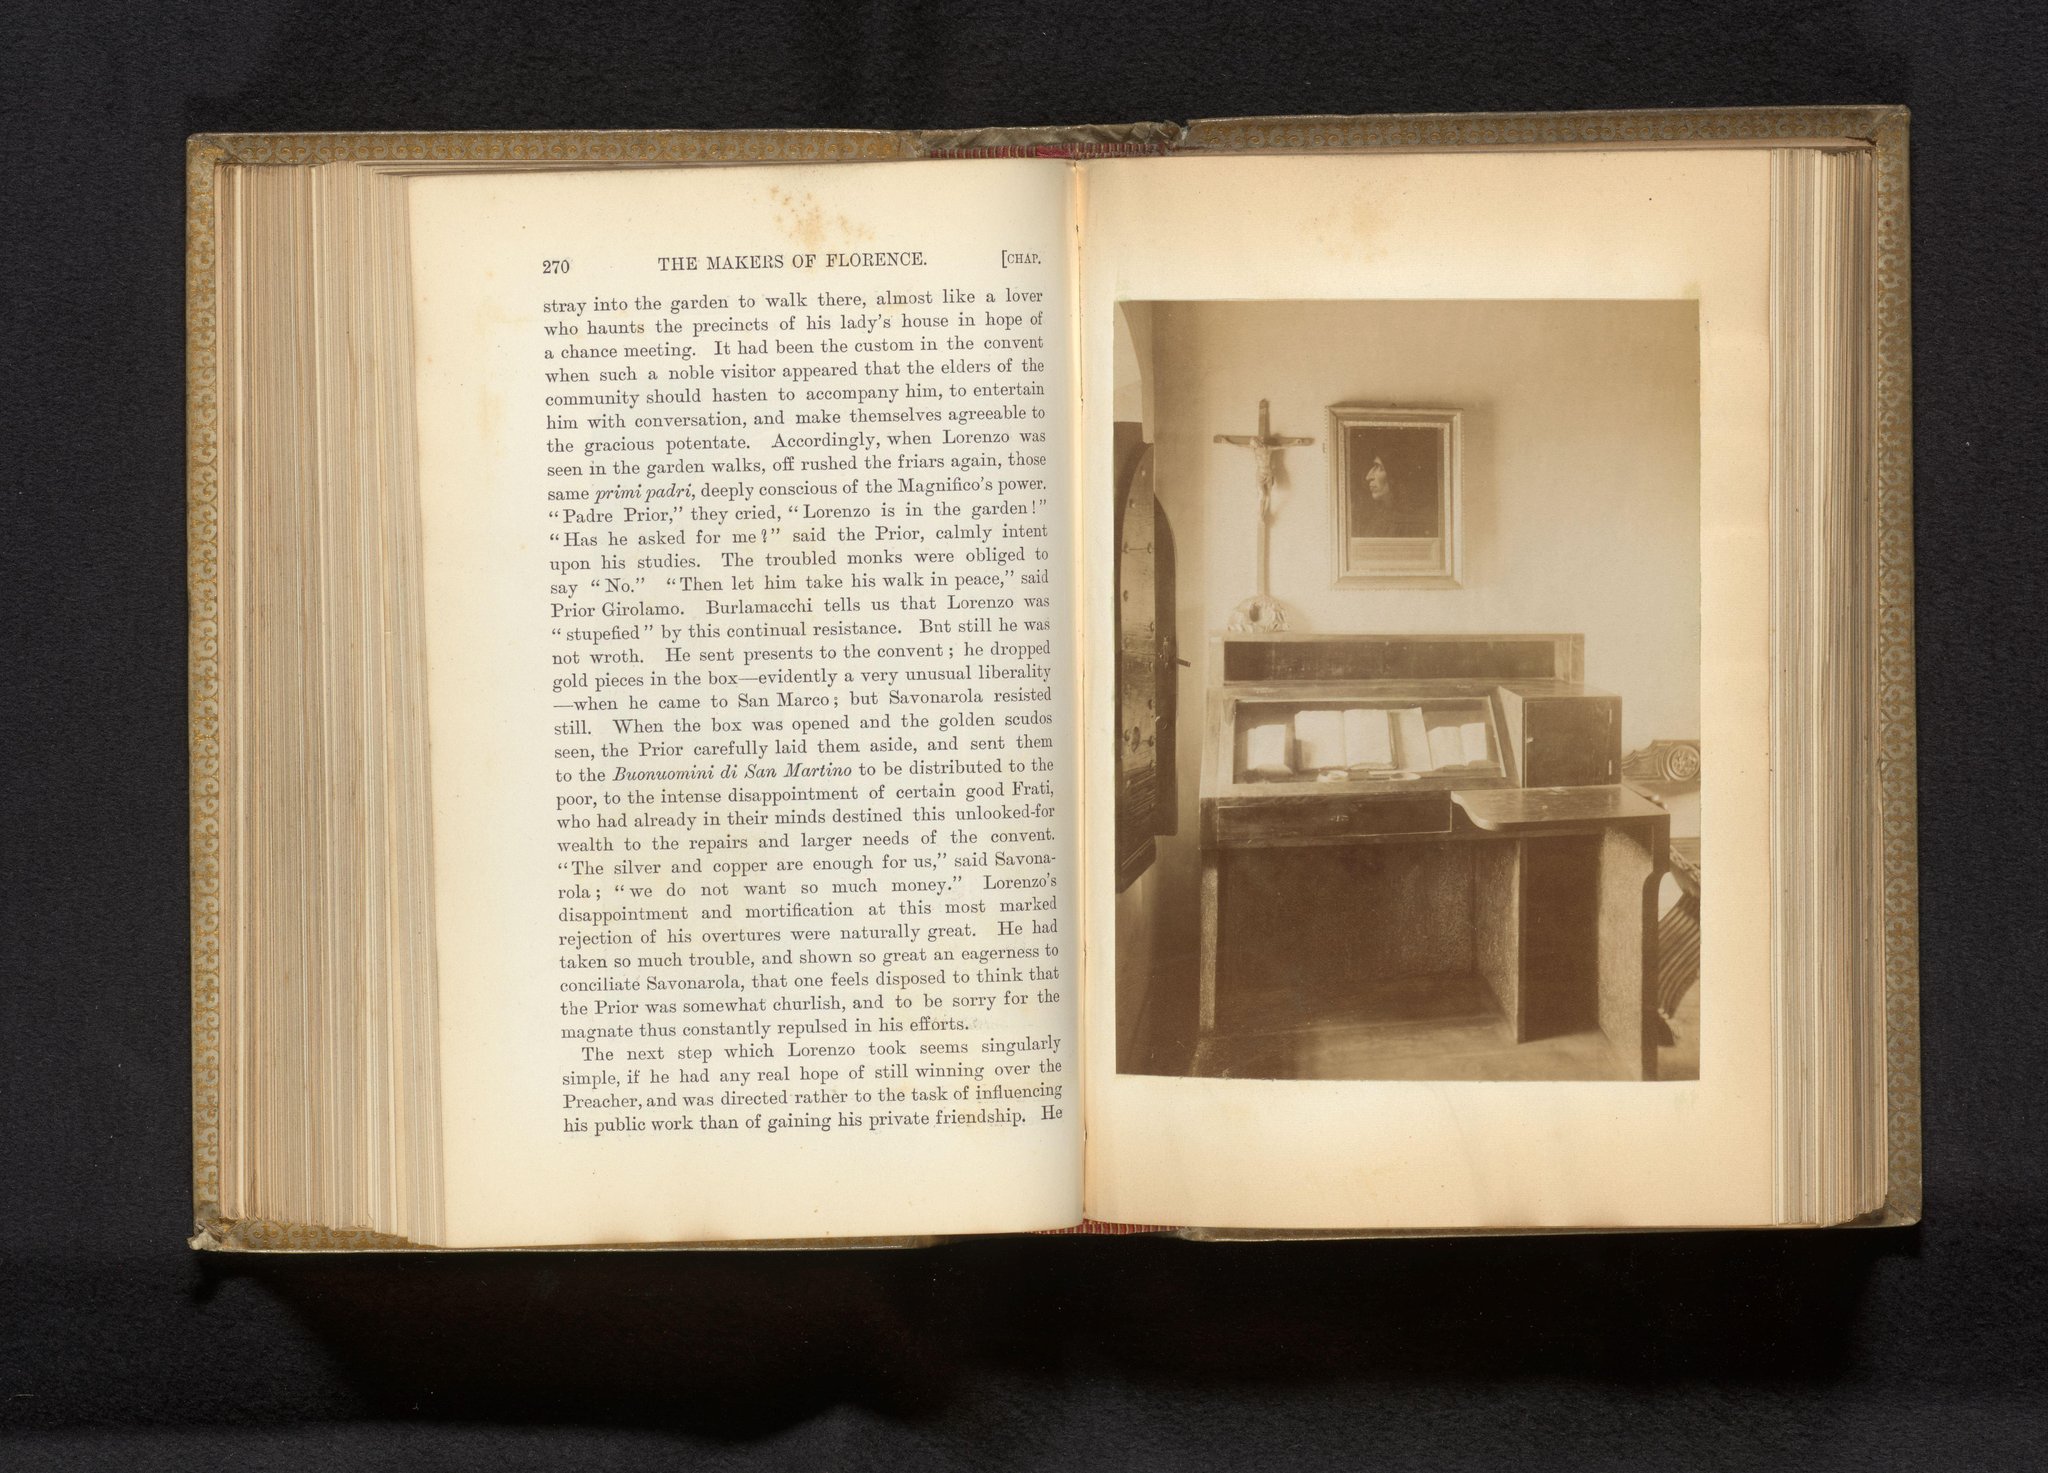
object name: page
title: Cel van Girolamo Savonarola in het San Marco-klooster te Florence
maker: Anonymous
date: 1878-1888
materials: photographic support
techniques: albumen print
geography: san marco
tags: cell ~ monastery, sculpture